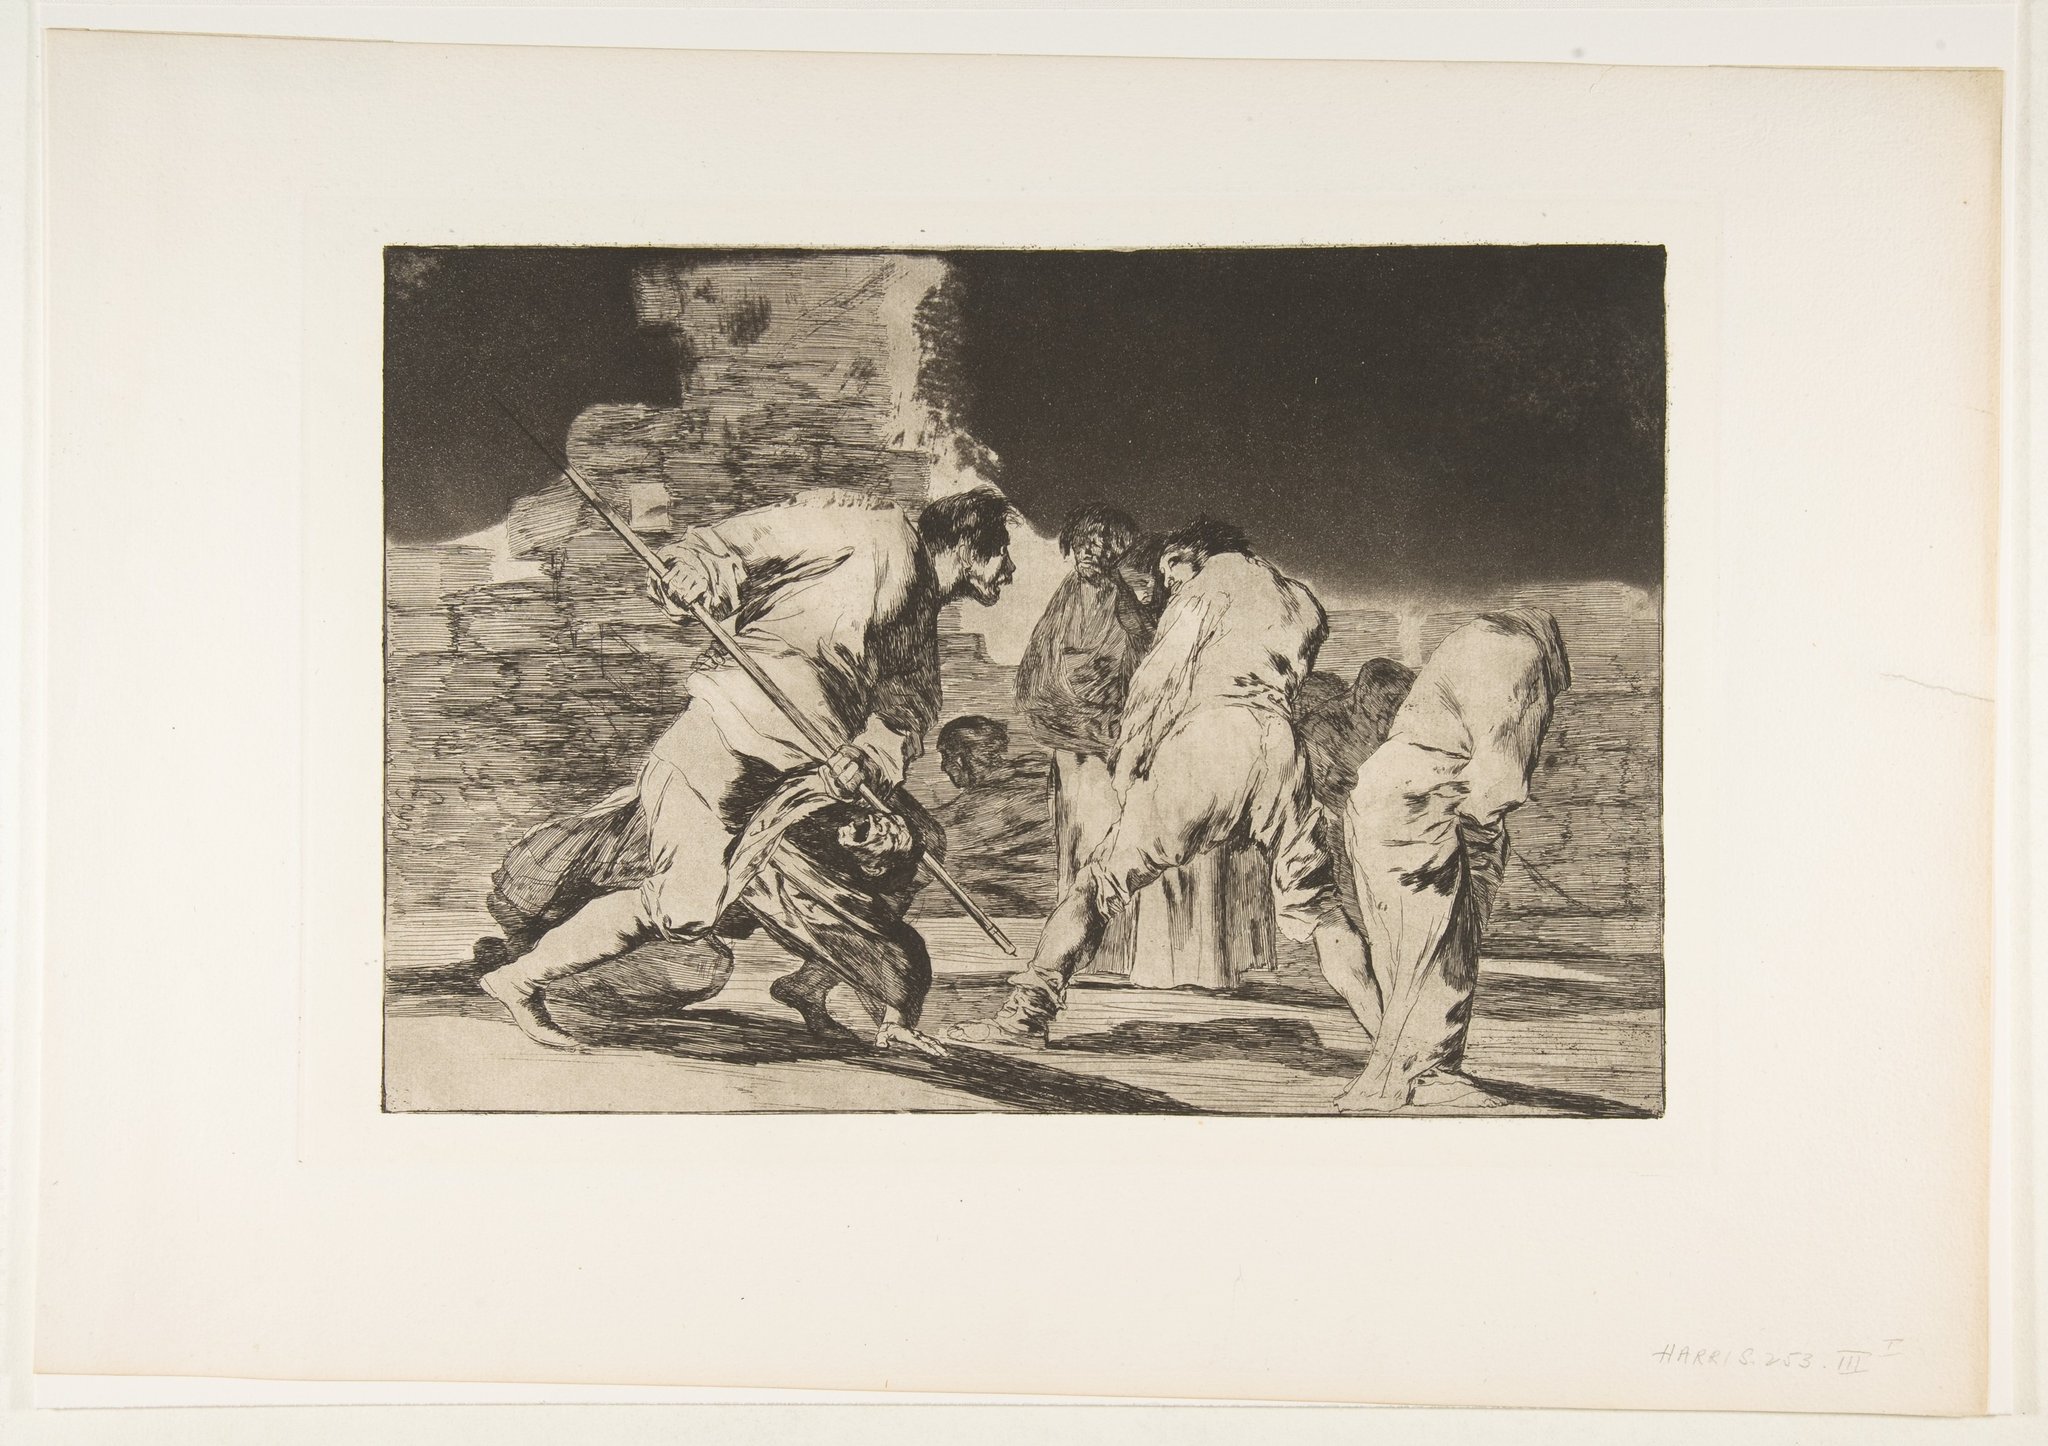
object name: print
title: Cruel Folly, from "The Disparates" (Follies / Irrationalities)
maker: goya (francisco de goya y lucientes)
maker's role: artist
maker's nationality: spanish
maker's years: 1746-1828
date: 1815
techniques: aquatint, burnishing, etching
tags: ruins,men